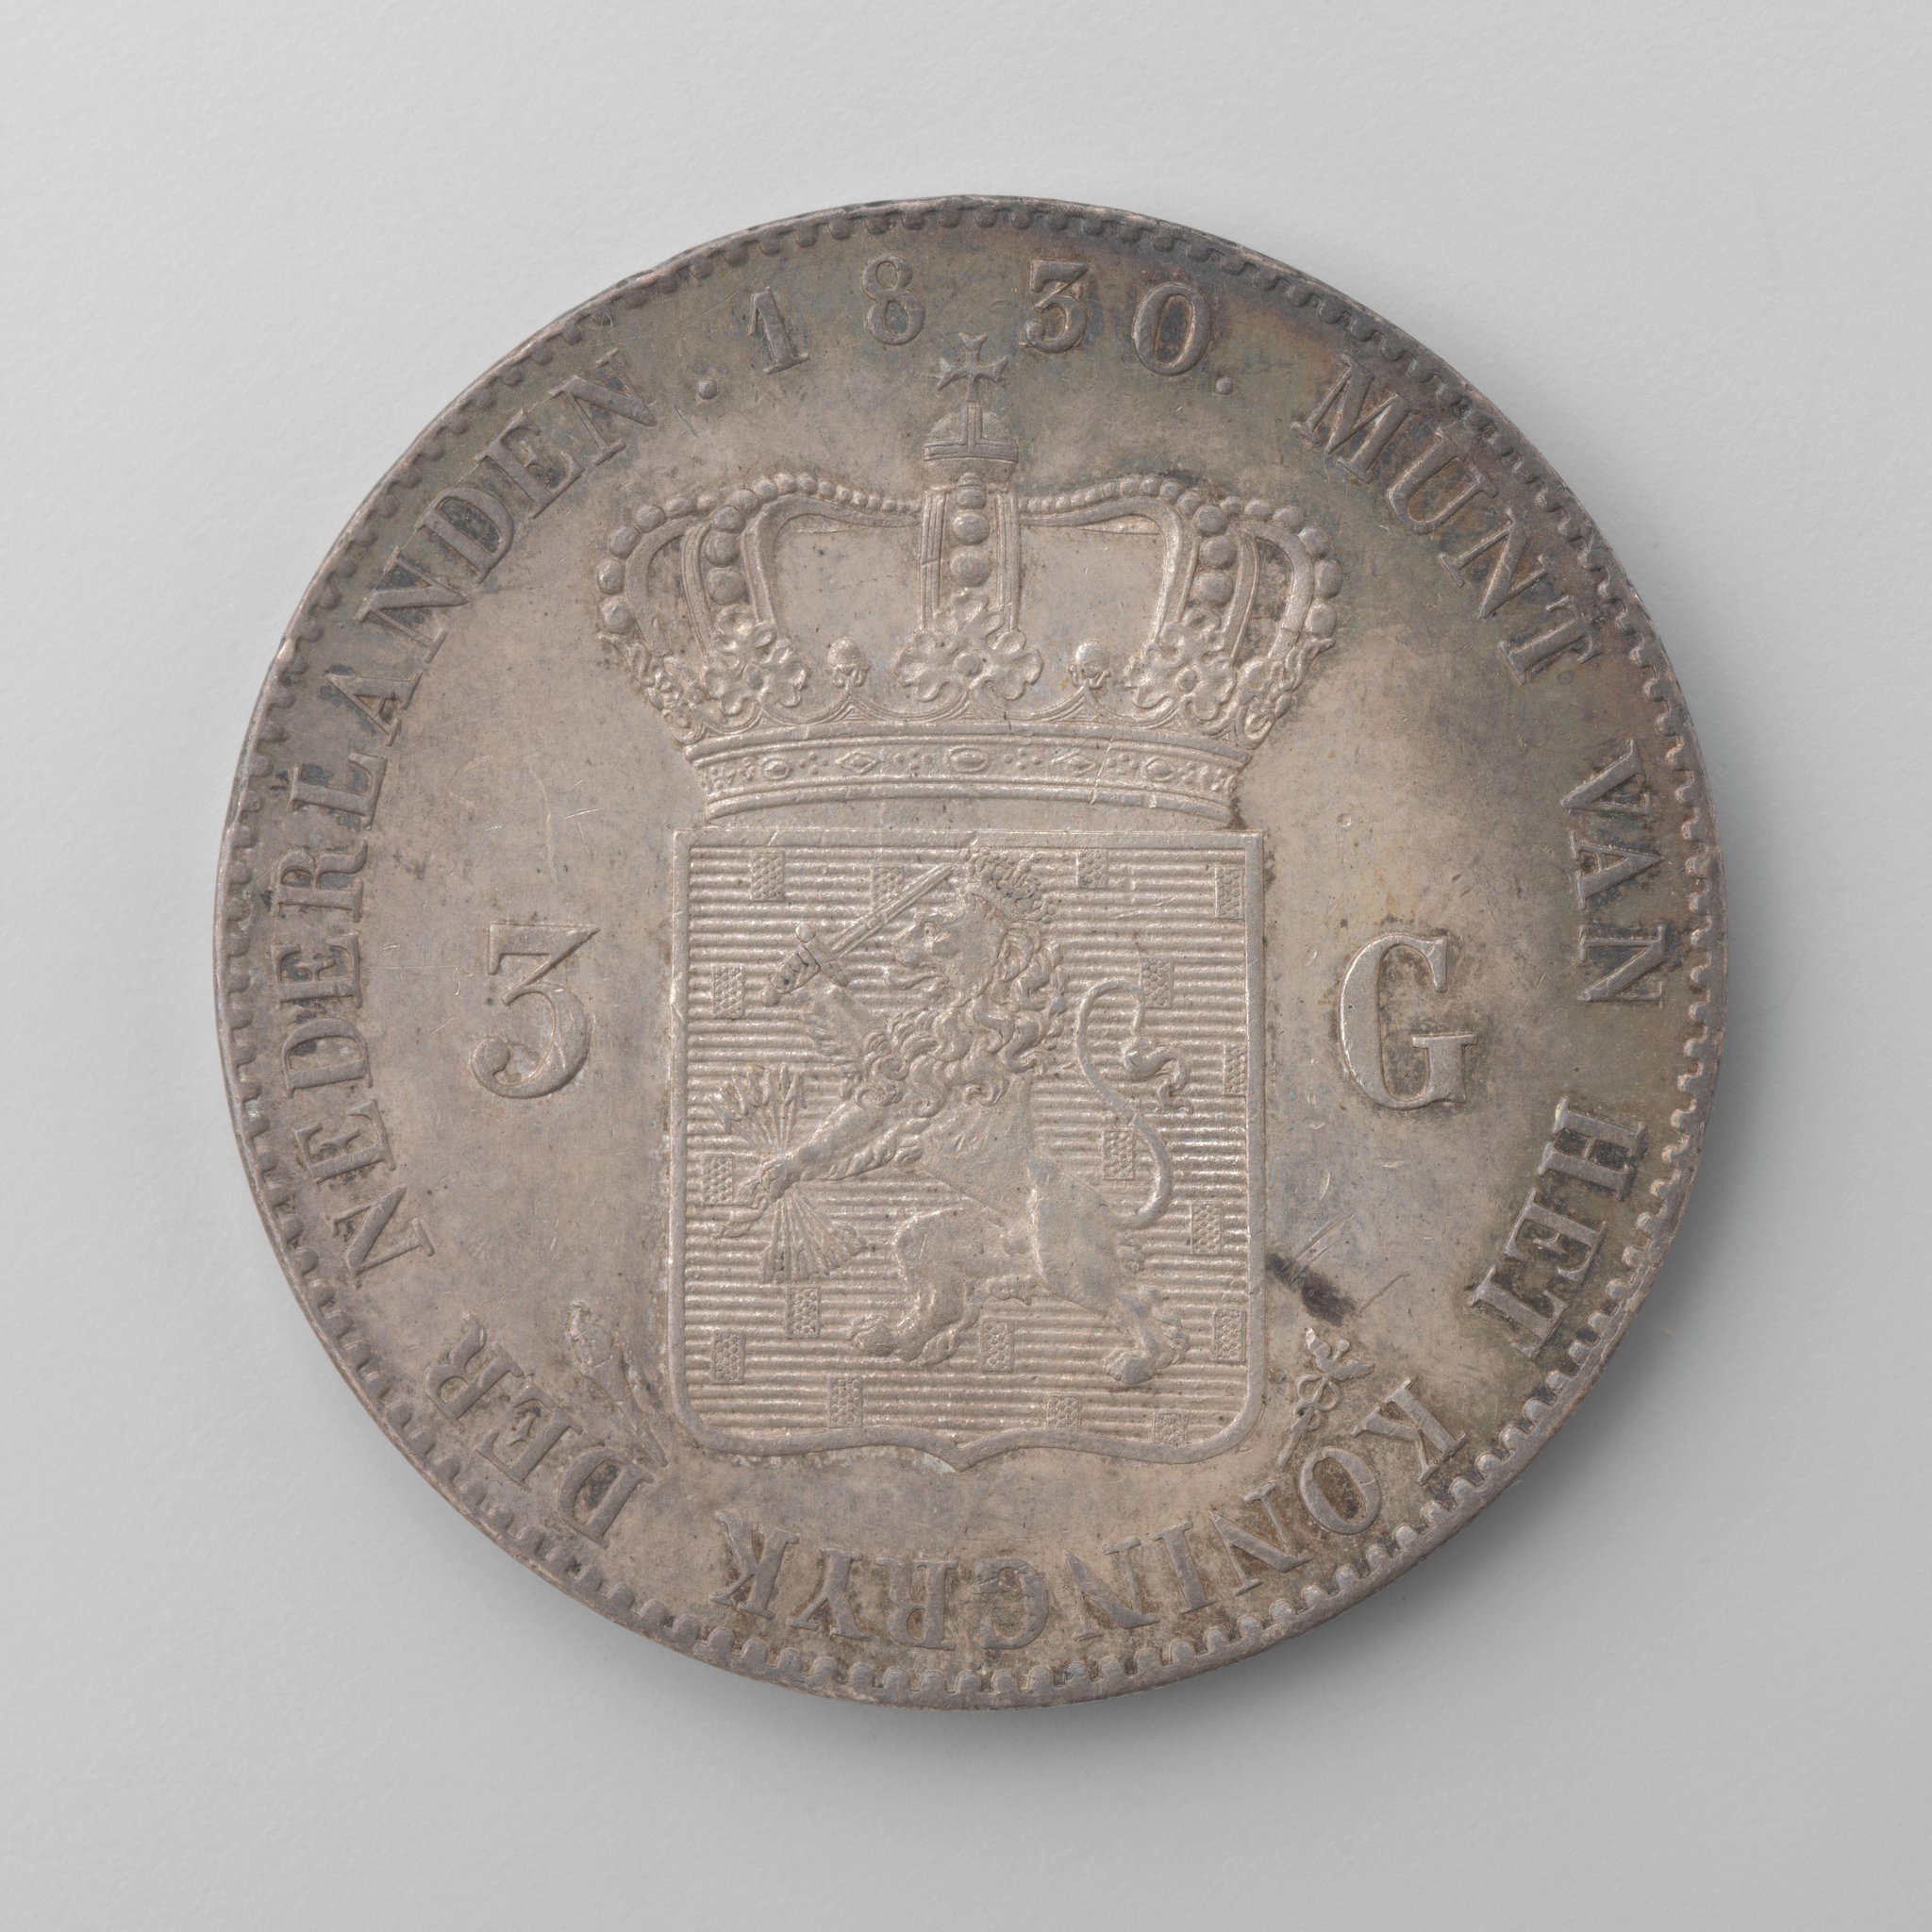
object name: coin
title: Nederland, 3 gulden,1830/20 Utrecht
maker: william i of the netherlands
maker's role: koning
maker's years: 1772-1843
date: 1830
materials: silver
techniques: striking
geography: utrecht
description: Zilveren munt. Voorzijde: borstbeeld naar rechts. Keerzijde: tussen waarde-aanduiding 3 G gekroond rijkswapenschild. Jaartal boven kroon. Randschrift. Gewijzigd jaartal uit1820.